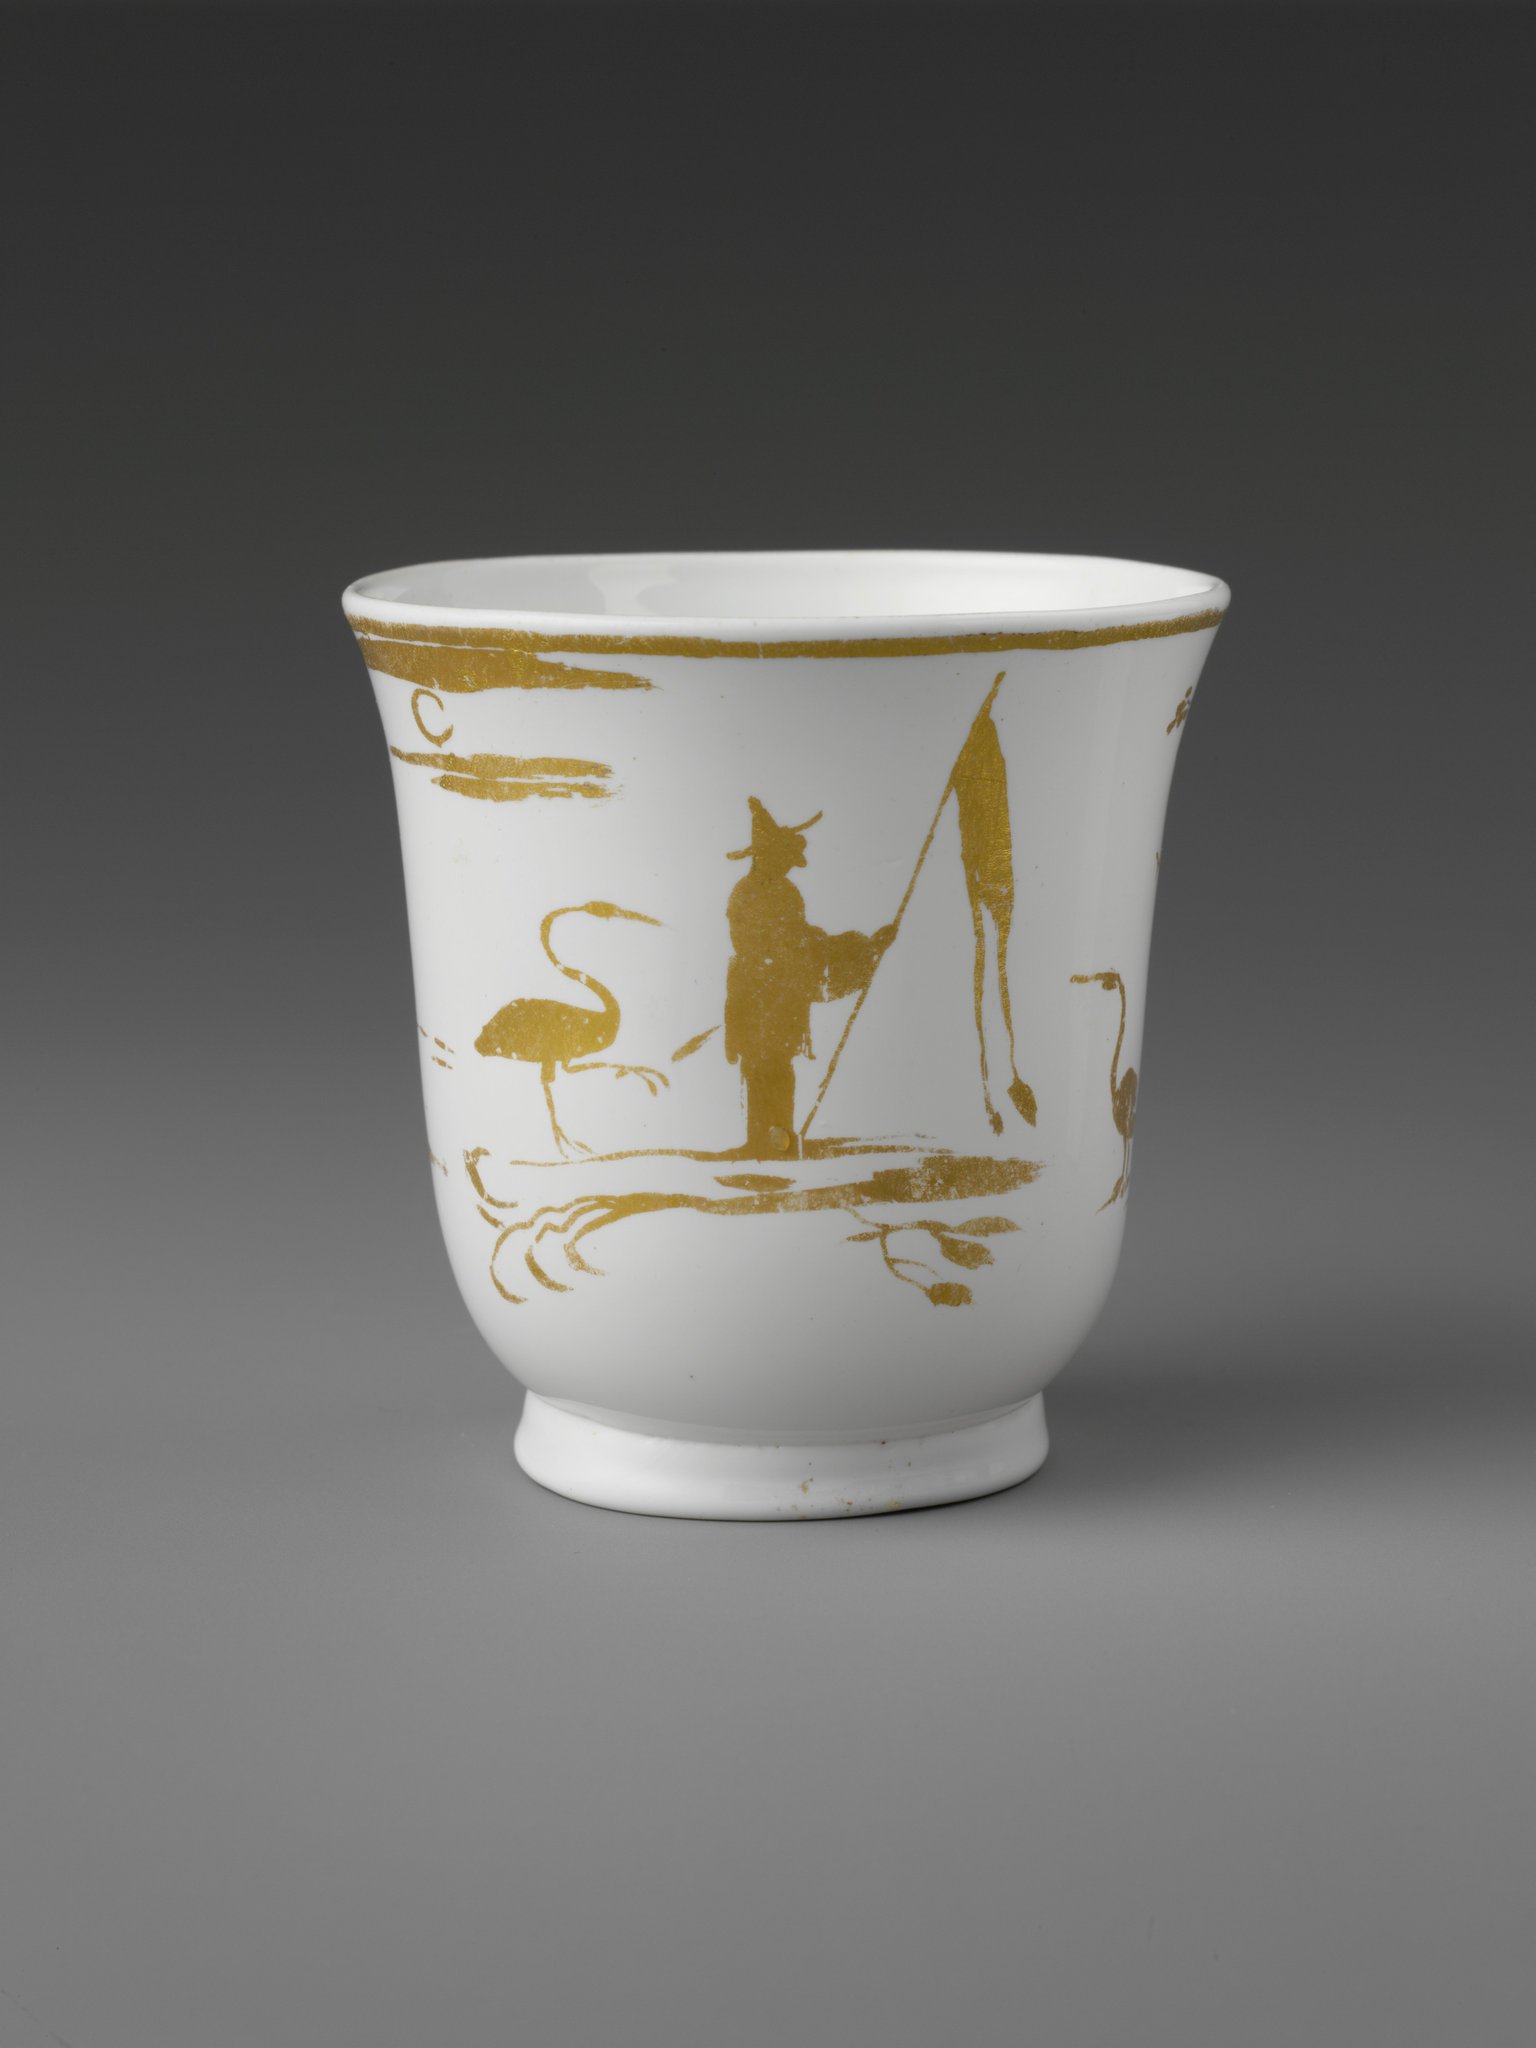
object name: cup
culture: german or italian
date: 1701-1800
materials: glass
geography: italy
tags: birds,men